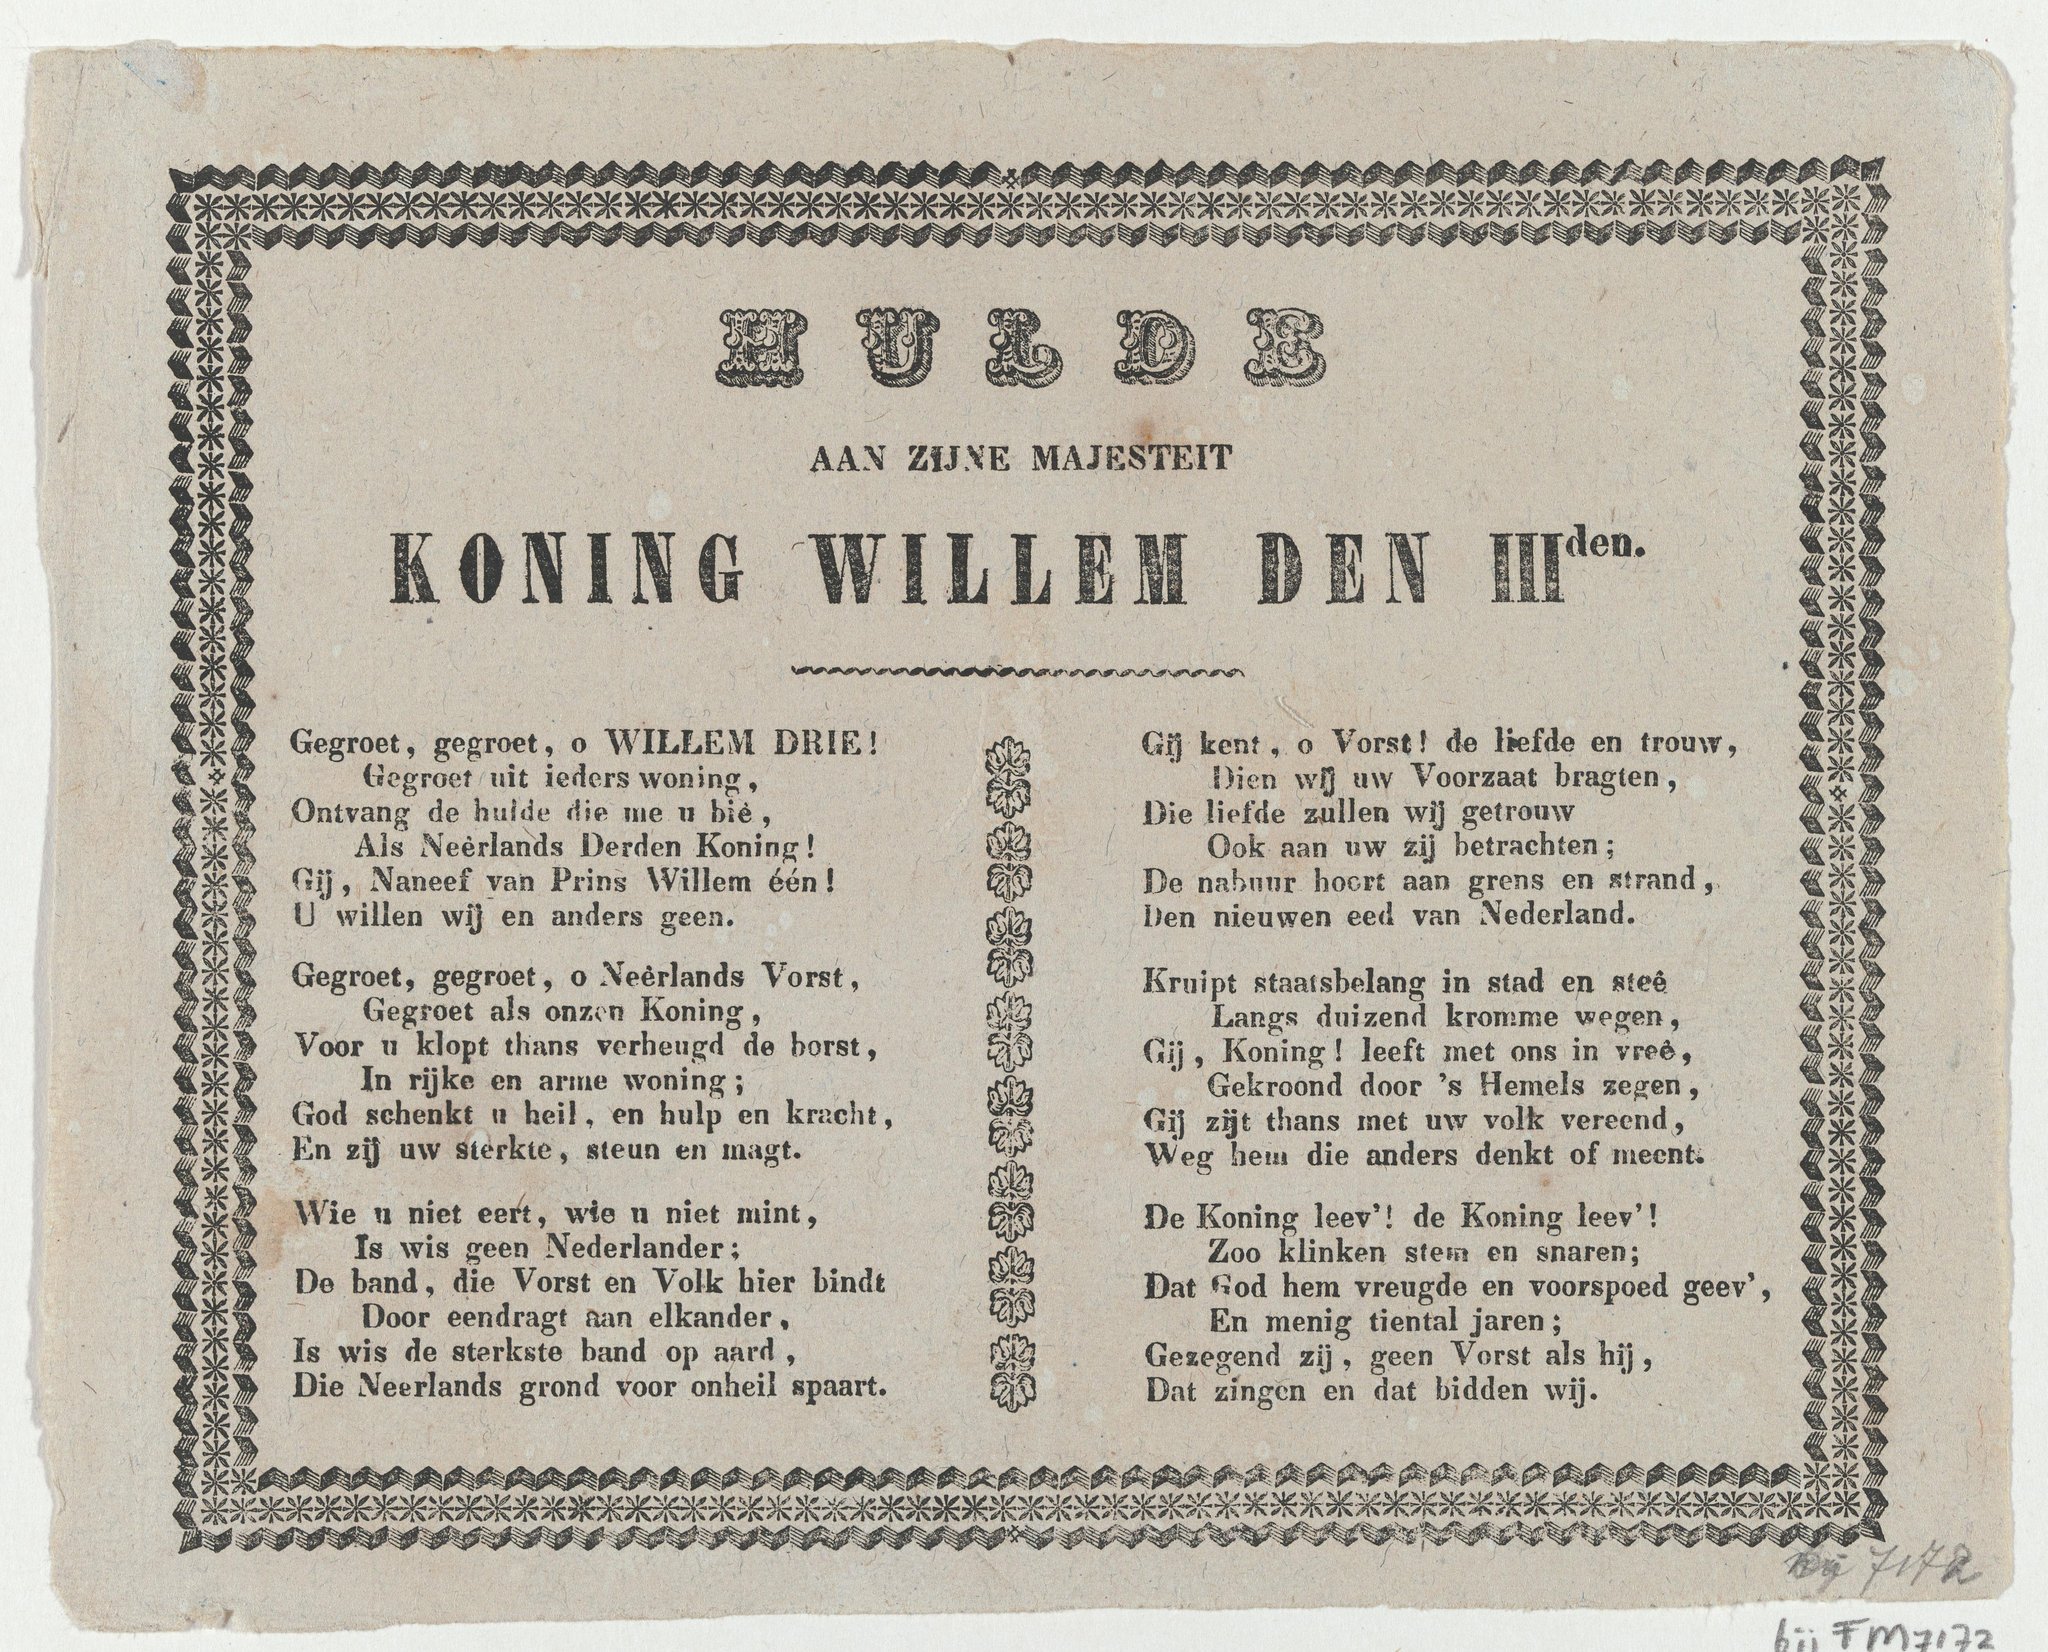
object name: text sheet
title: Hulde aan zijne Majesteit Koning Willem den IIIden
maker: Anonymous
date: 1849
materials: paper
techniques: letterpress printing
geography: netherlands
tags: willem iii (koning der nederlanden)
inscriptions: collector's mark: Lugt 2228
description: Vers op de inhuldiging van koning Willem III op 12 mei 1849. Tekst in zes coupletten in twee kolommen.